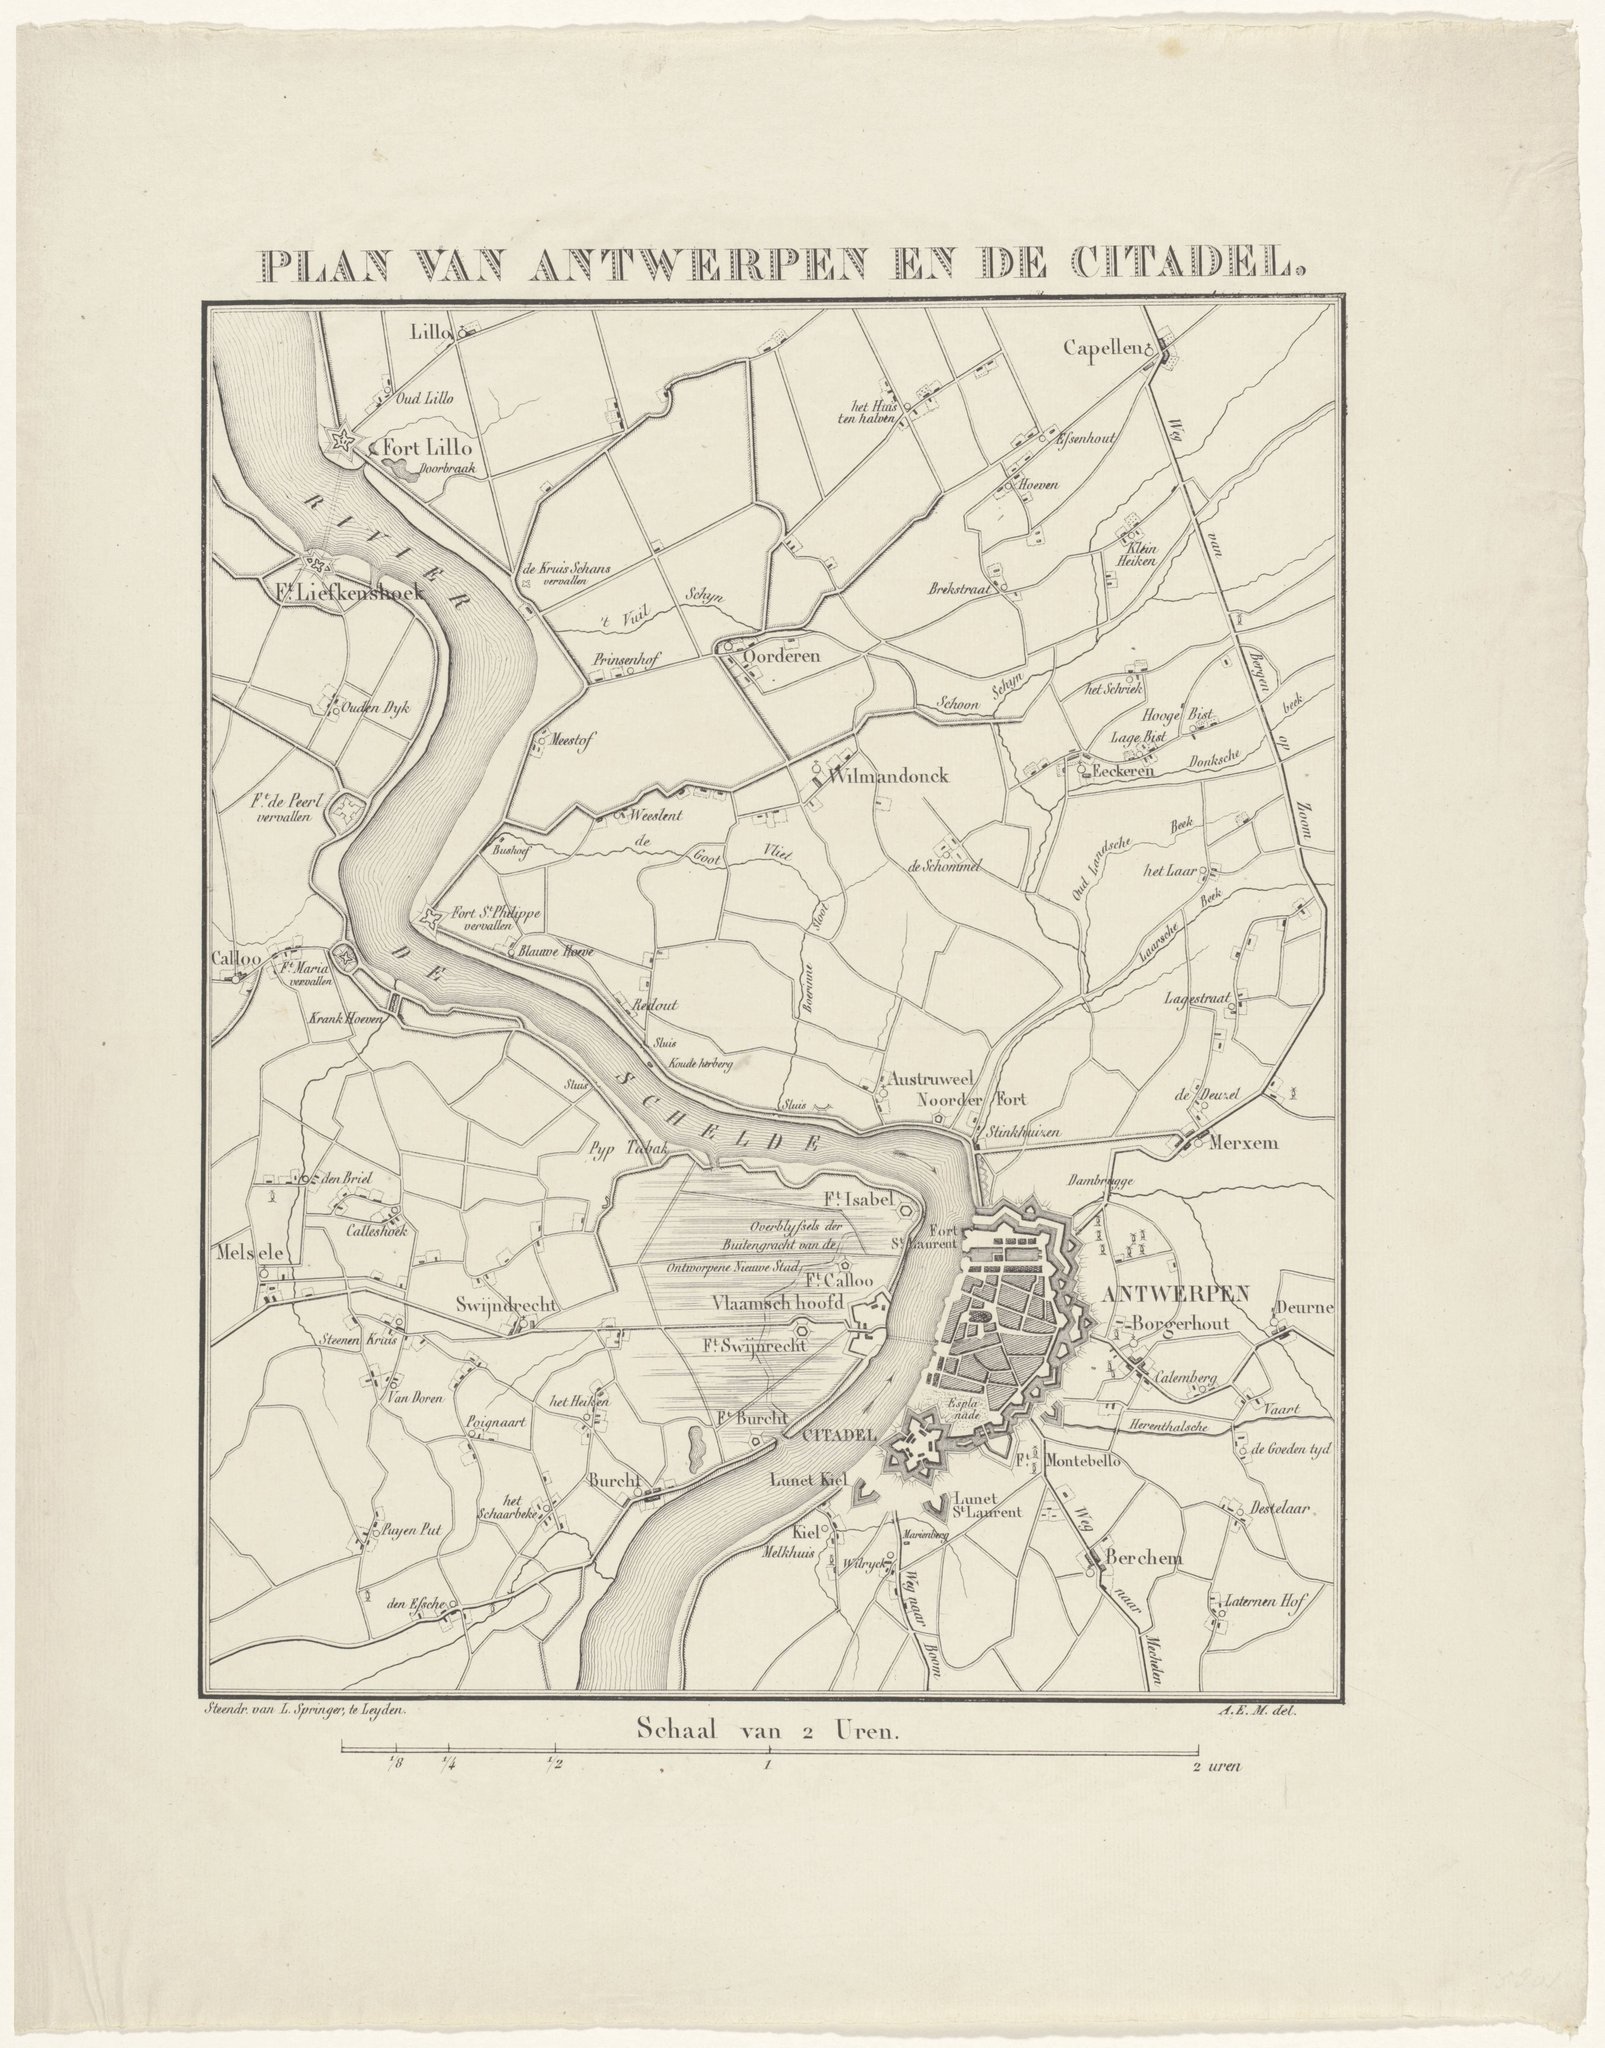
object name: map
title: Plan van Antwerpen en de Citadel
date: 1832-1833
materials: paper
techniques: lithograph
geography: netherlands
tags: maps of separate countries or regions, antwerp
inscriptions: collector's mark: Lugt 2228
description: Muller plaatst de prenten 6529-6538 bij het jaar 1830, ze passen echter beter bij het jaar 1832.